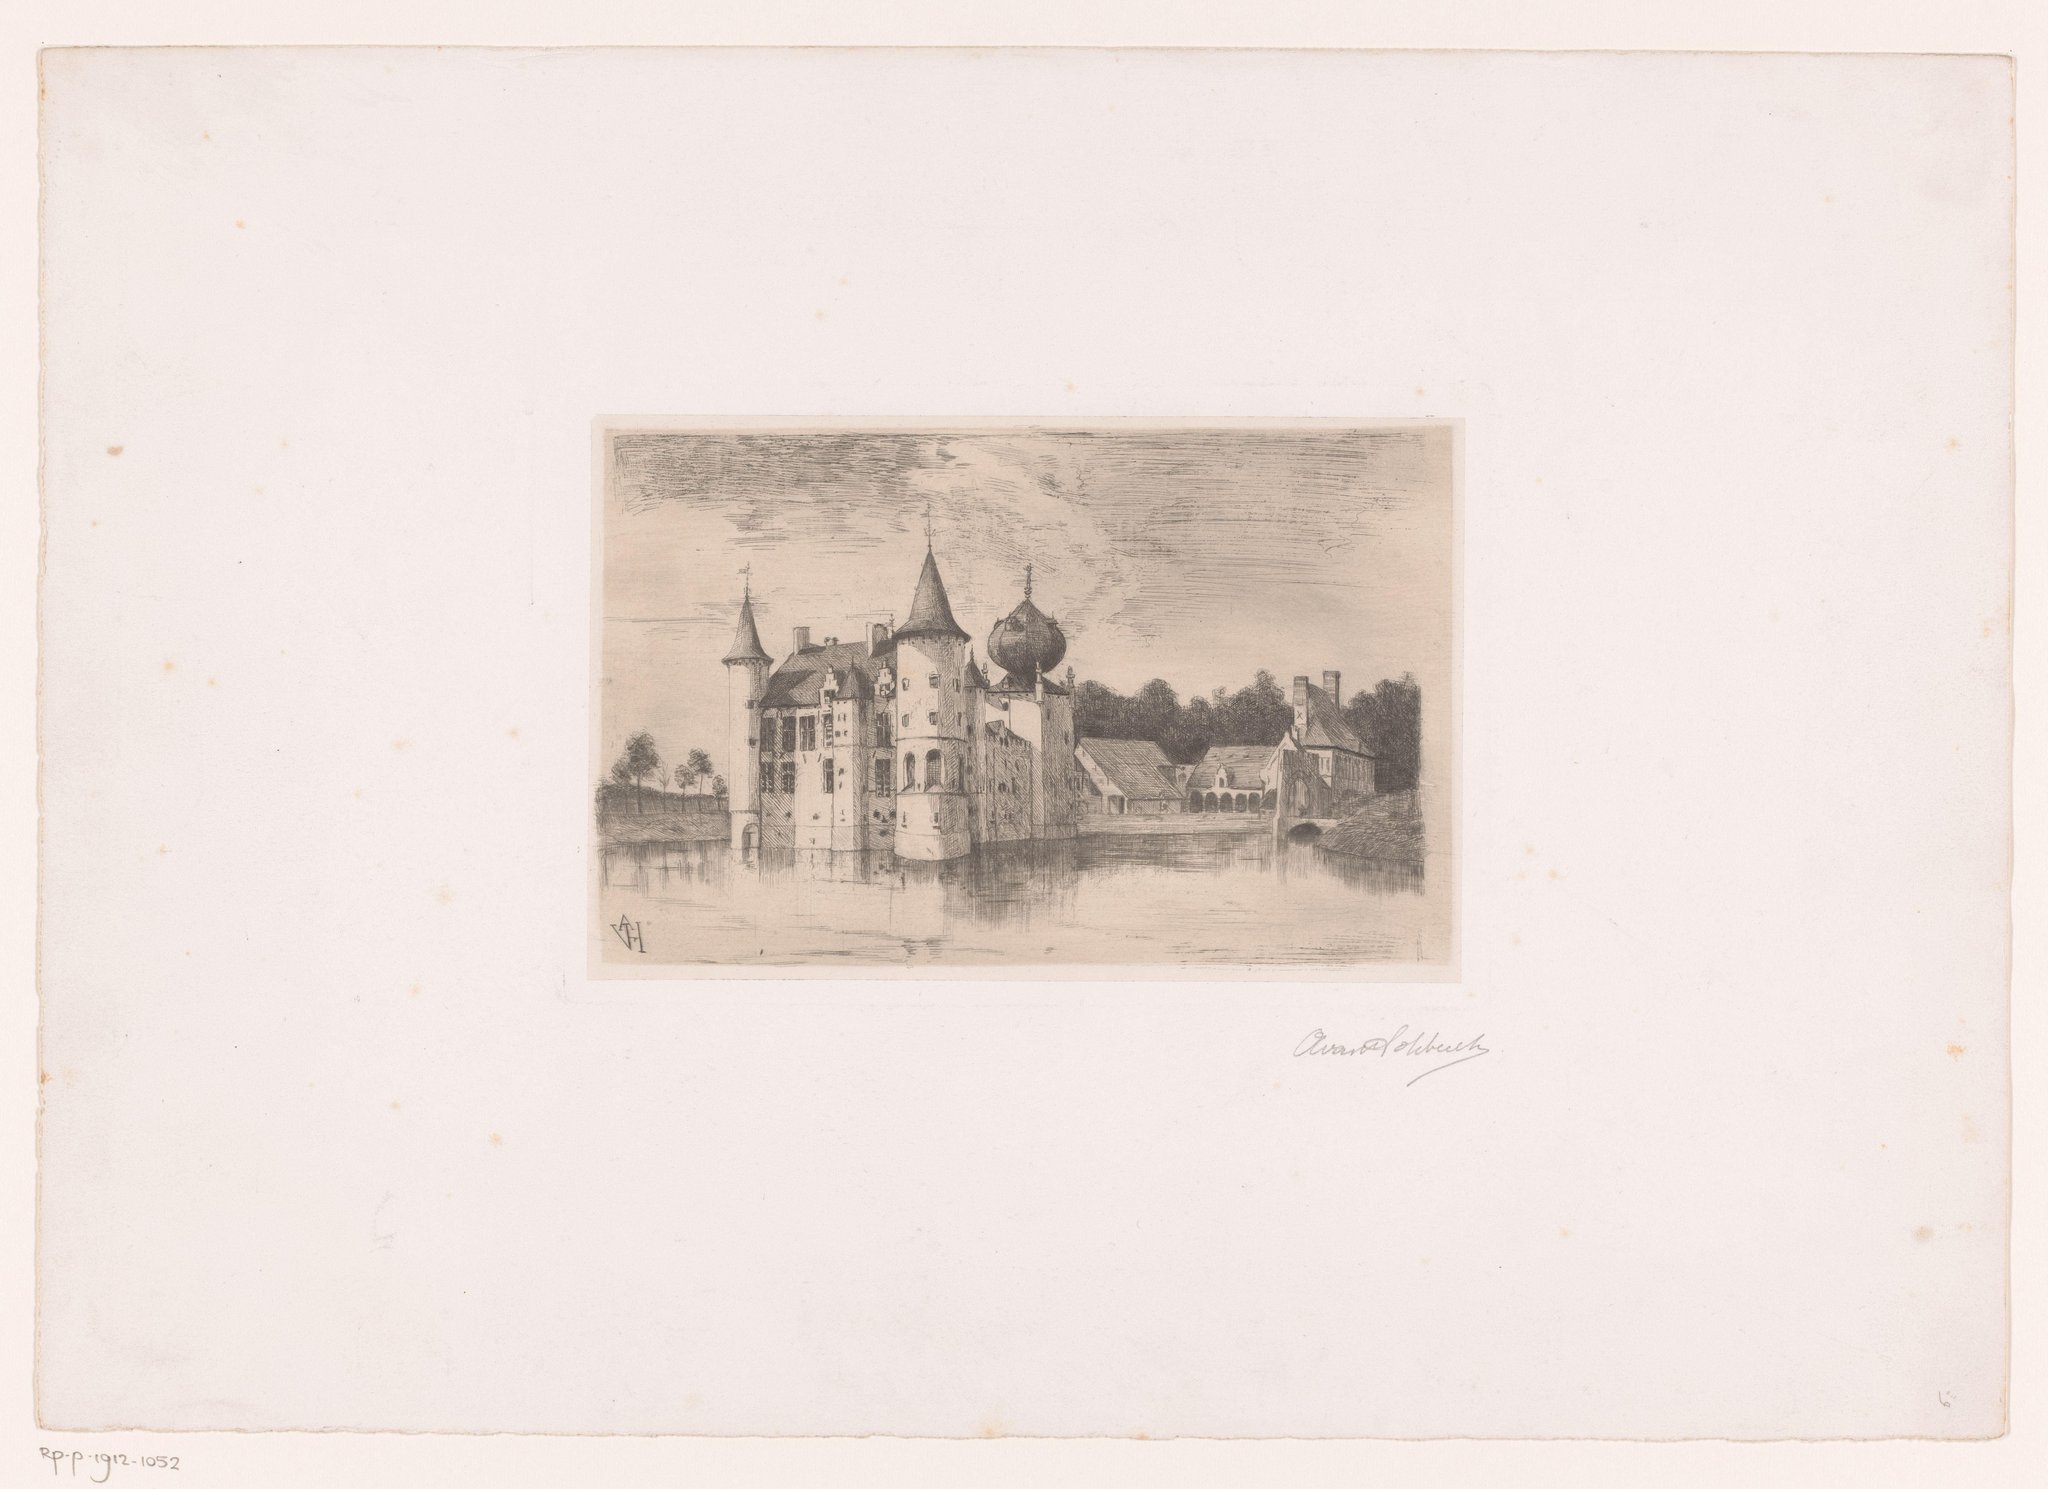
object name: print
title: Gezicht op het kasteel van baron Henri van Havre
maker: albert van holsbeeck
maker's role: print maker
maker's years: 1877-1948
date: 1887-1912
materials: paper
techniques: etching, intaglio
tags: castle, landscape with tower or castle, hemiksem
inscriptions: collector's mark: Lugt 2228, annotation: ‘chateau de Mr. le Baron H van Havre Hemixem’